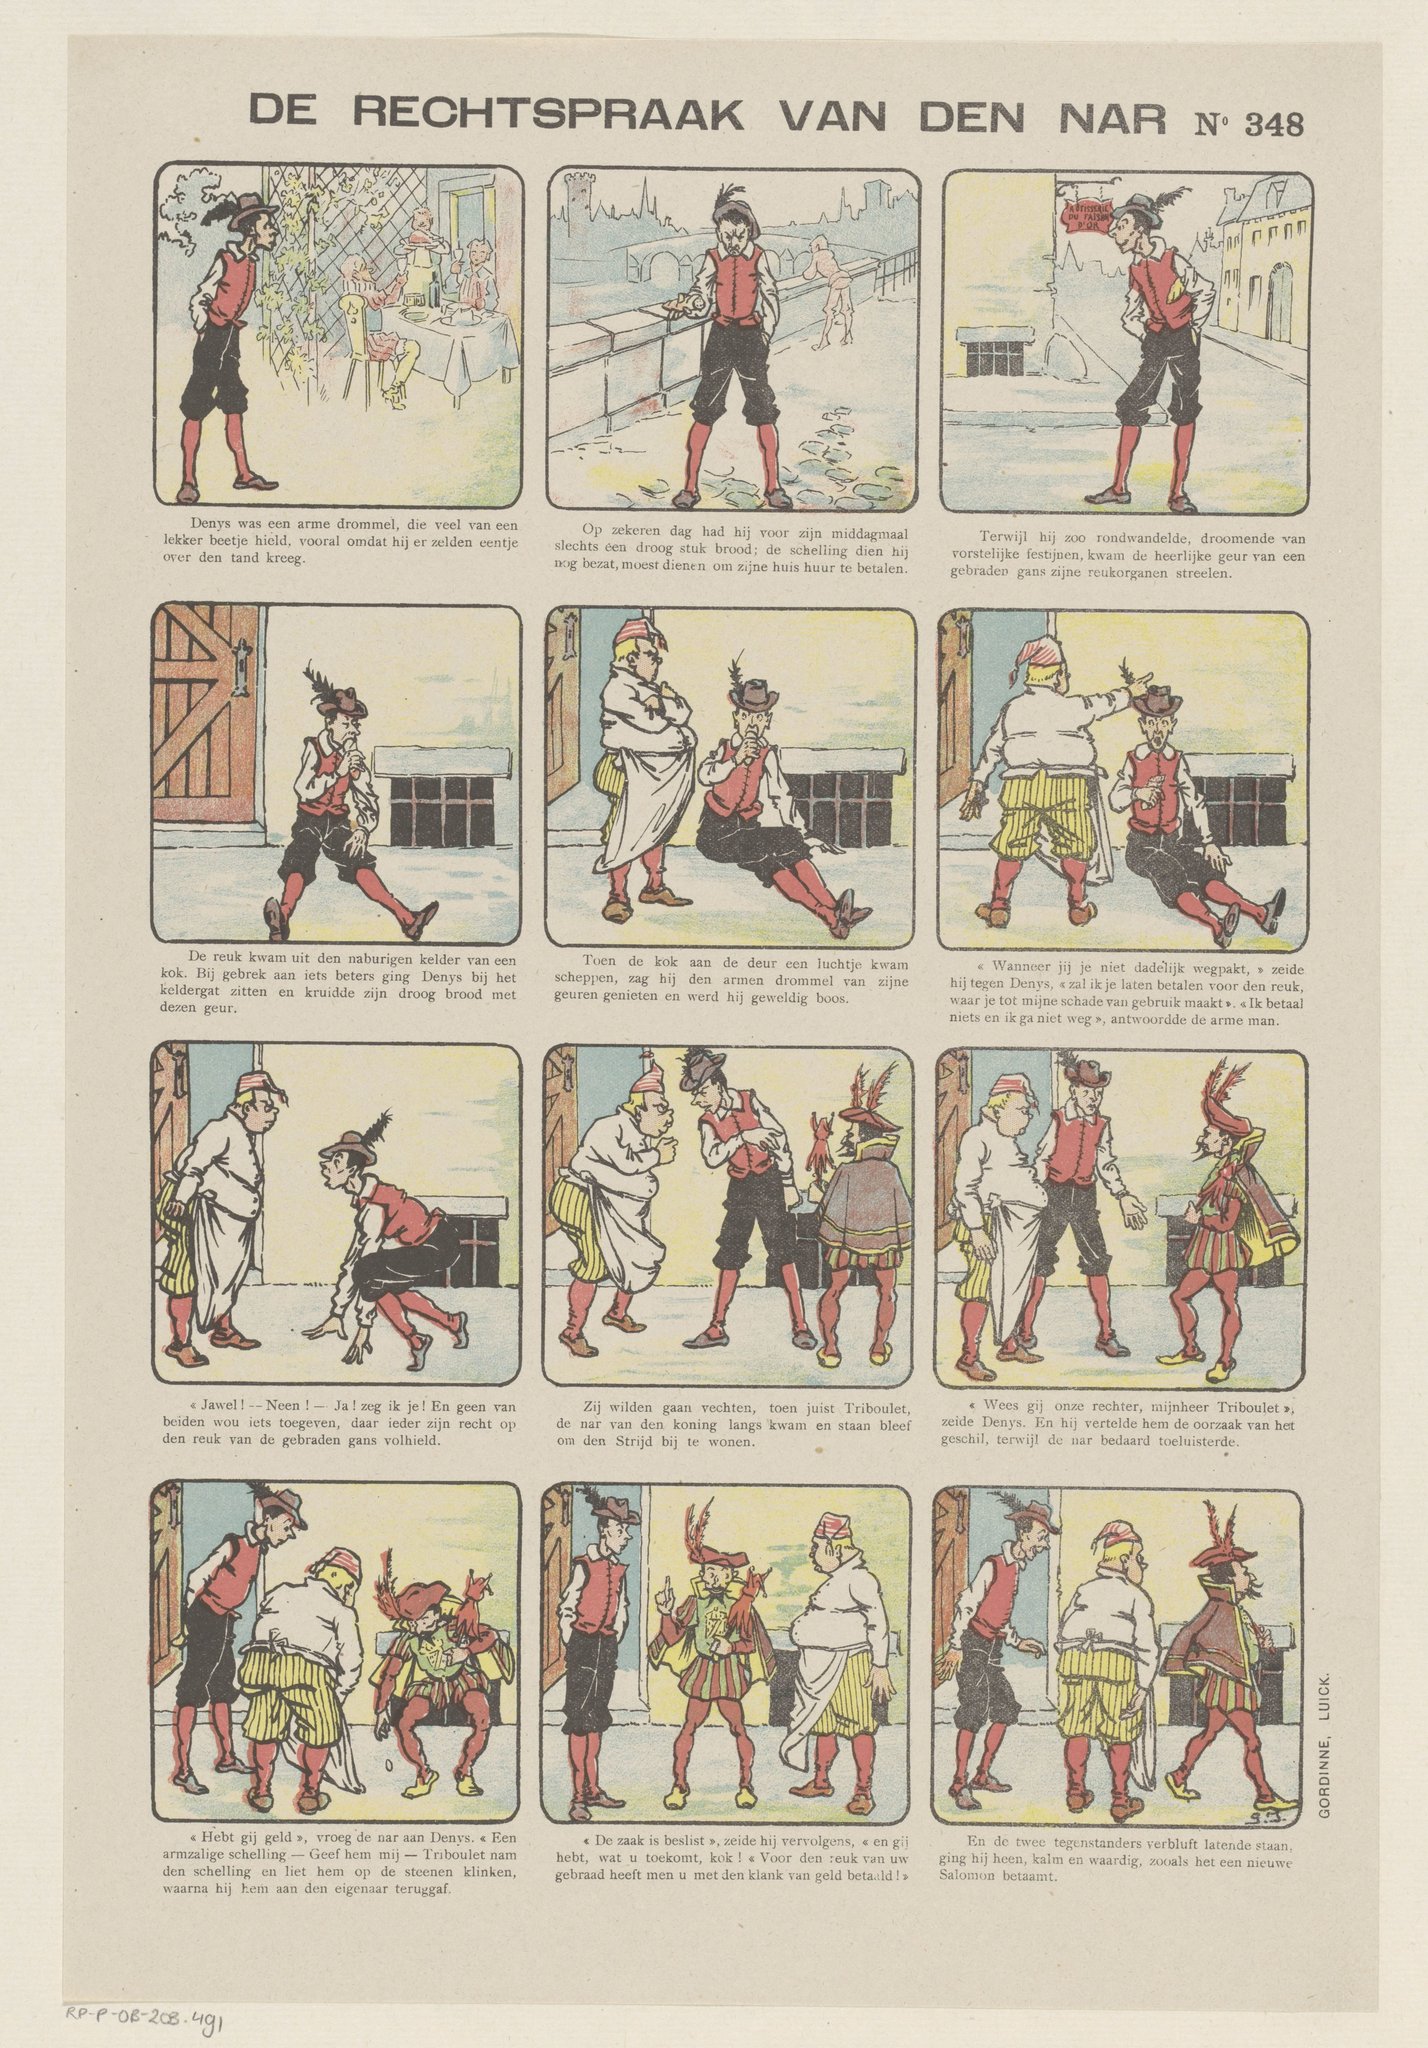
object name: print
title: De rechtspraak van den nar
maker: monogrammist g.j.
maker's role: print maker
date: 1894-1959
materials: paper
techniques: lithograph, letterpress printing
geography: liège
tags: court jester, court fool, wisdom of the fool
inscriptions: collector's mark: Lugt 2760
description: Blad met 12 voorstellingen over een kok die wil dat een arme drommel voor de geur van zijn gebraden gans betaalt. De hofnar Triboulet lost het geschil op. Onder elke afbeelding een onderschrift. Genummerd rechtsboven: No 348.